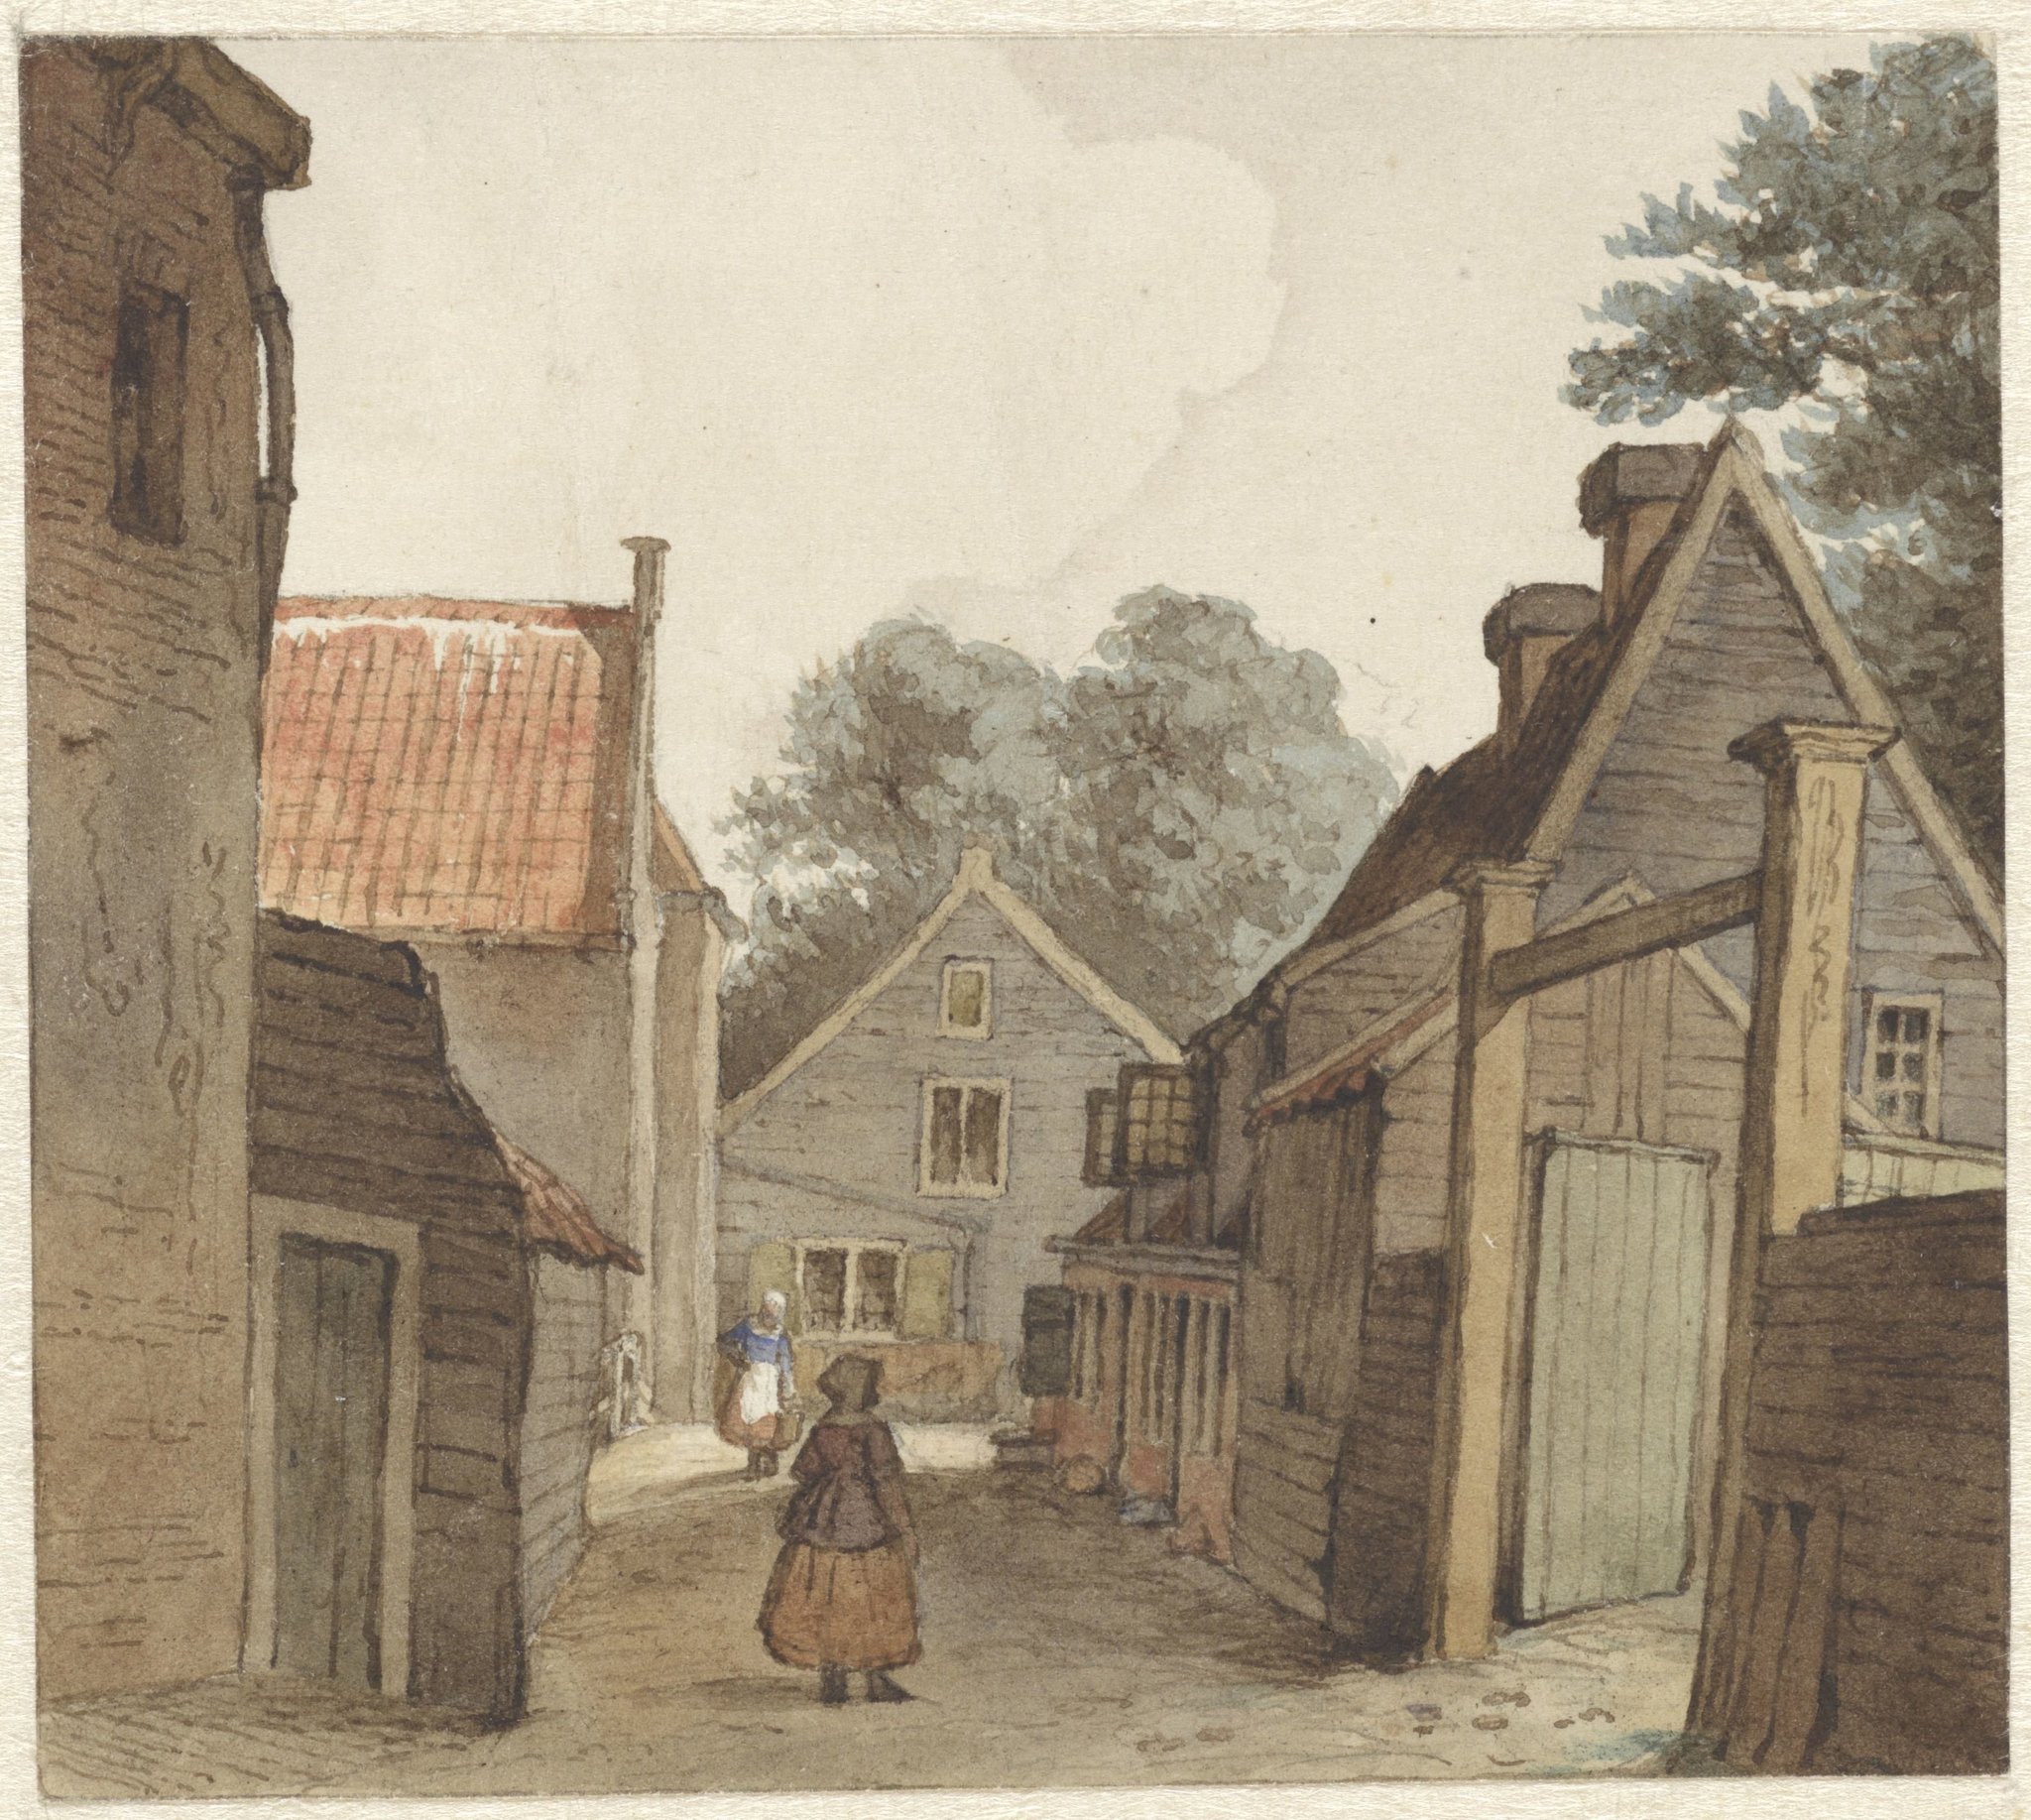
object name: watercolor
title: Straat bij de Manege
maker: hendrik abraham klinkhamer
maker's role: draughtsman, painter, print maker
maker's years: 1810-1872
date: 1820-1872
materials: ink, paper, pencil, watercolor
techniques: brush, pen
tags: prospect of village, silhouette of village